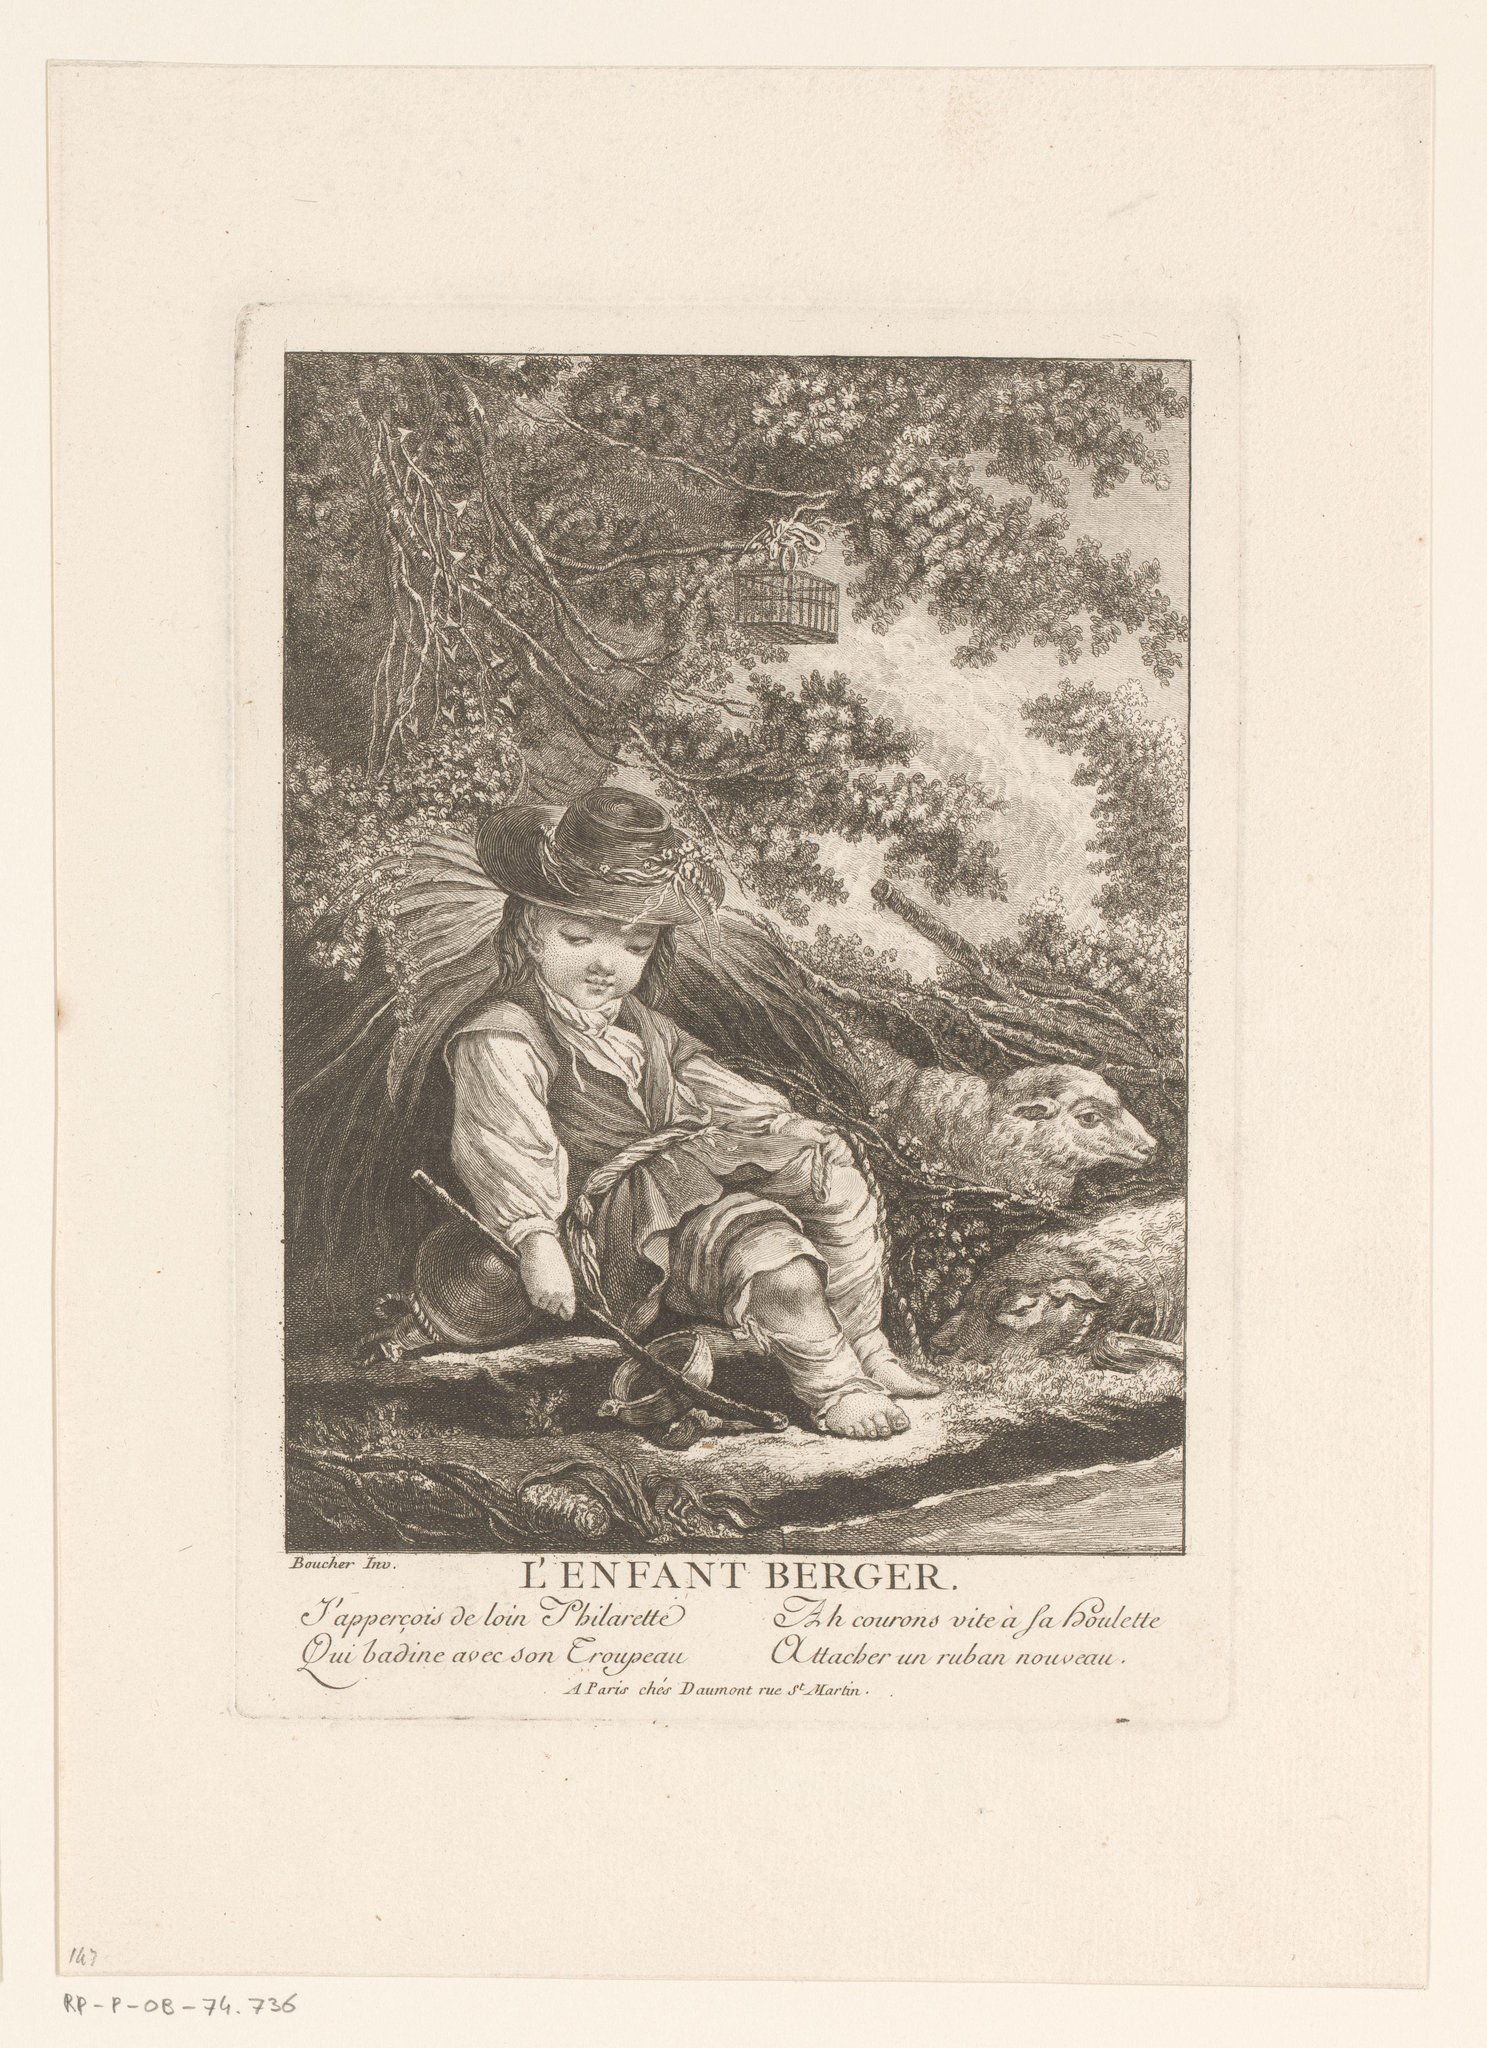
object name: print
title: Jonge herder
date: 1745-1775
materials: paper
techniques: engraving, etching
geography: paris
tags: herding, herdsman, herdswoman, shepherd, shepherdess, cowherd, etc., child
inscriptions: collector's mark: Lugt 240